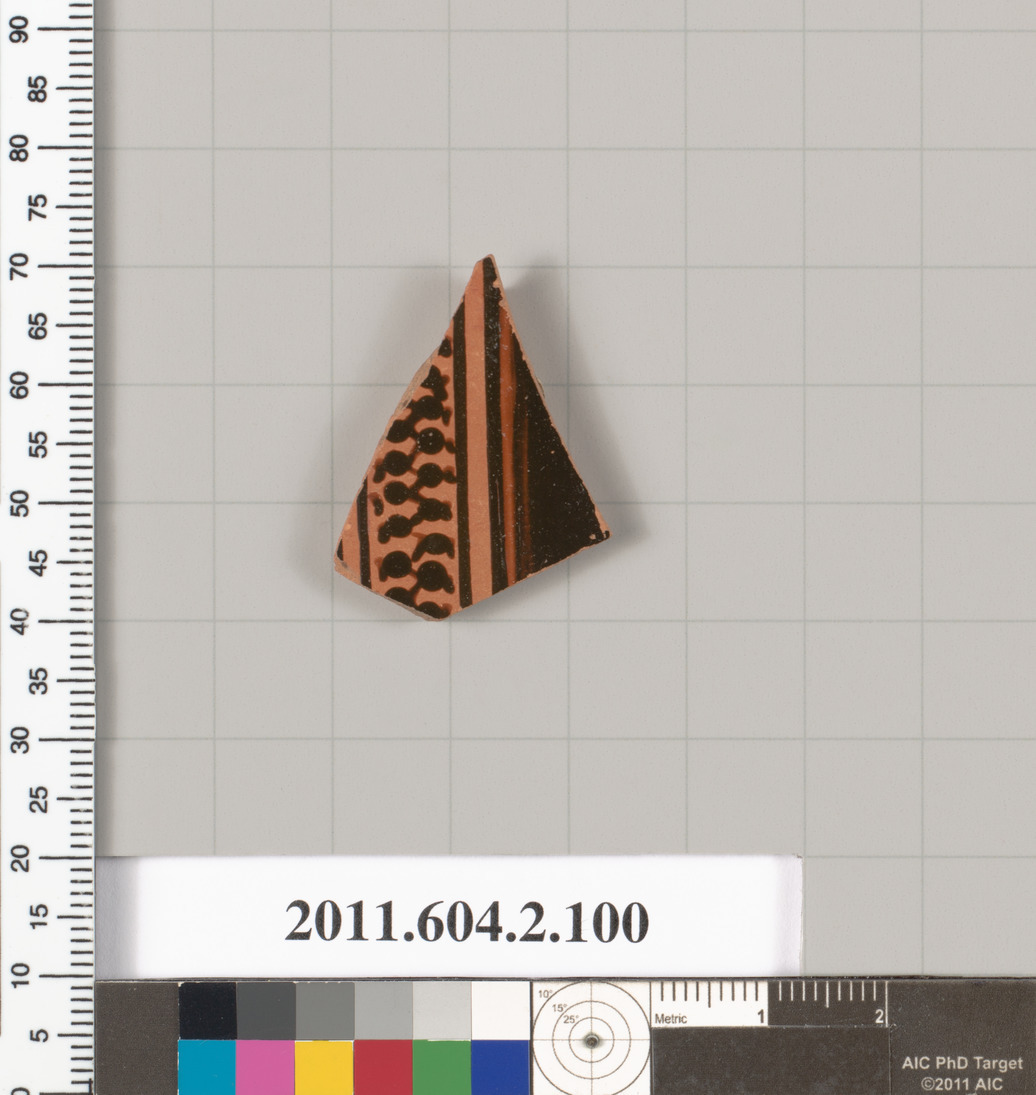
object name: pelike fragment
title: Terracotta fragment of a pelike (jar)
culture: greek, attic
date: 500-480 BCE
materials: terracotta